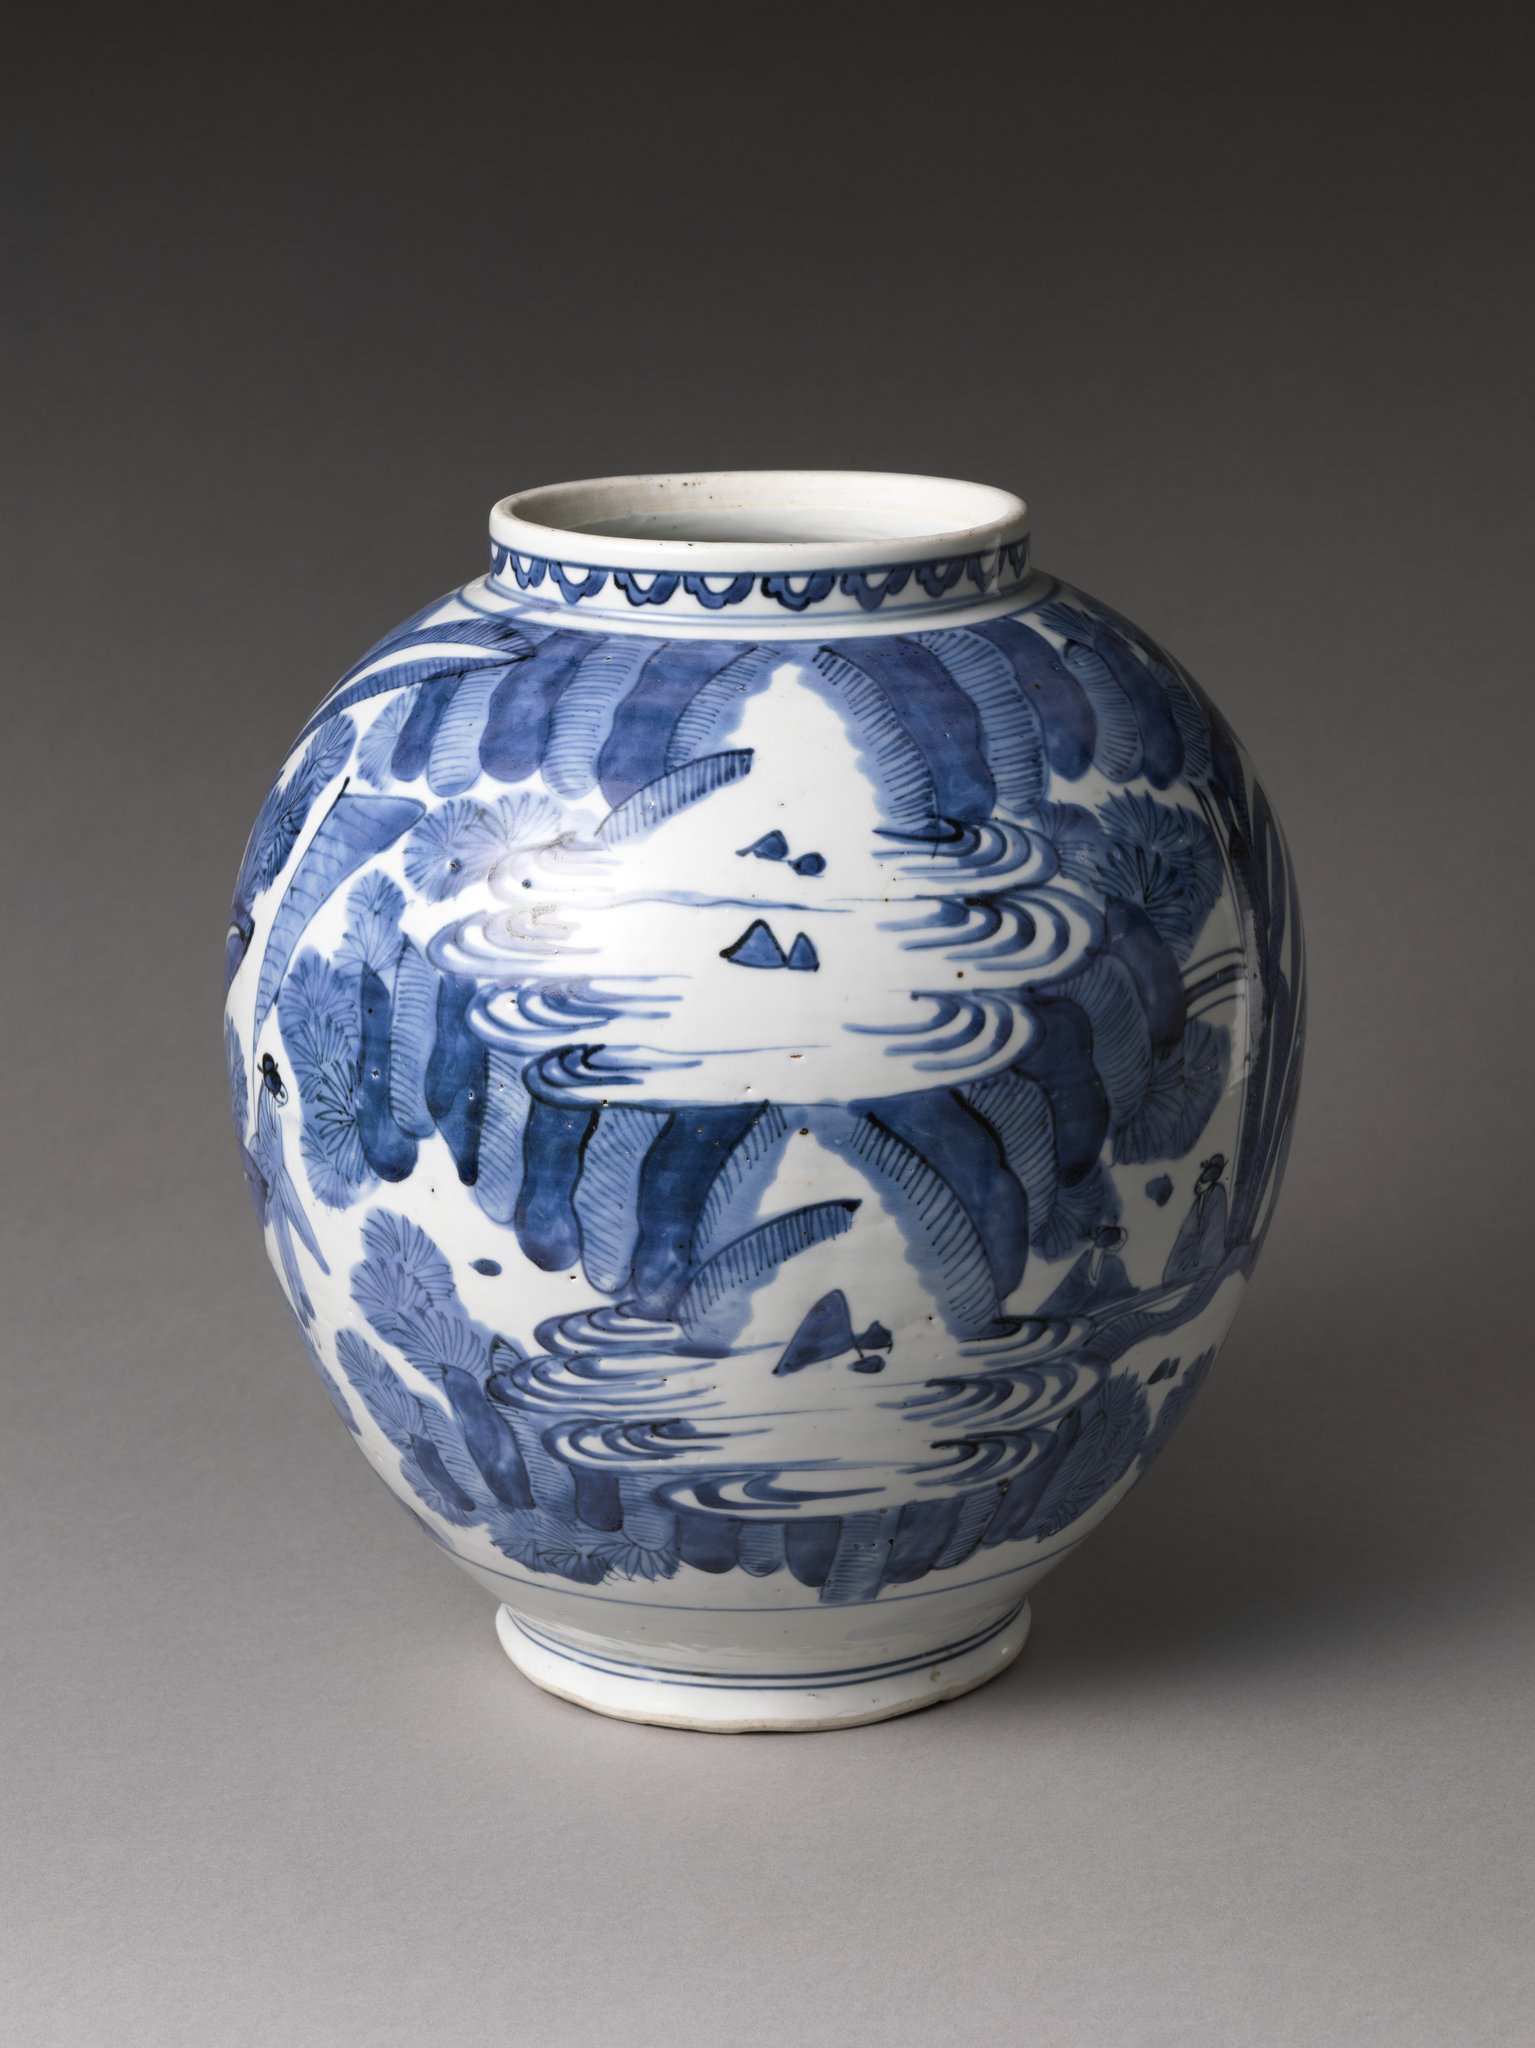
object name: vase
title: Vase with Figures in Landscape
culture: japanese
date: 1660-1680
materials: cobalt, glaze, porcelain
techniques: painting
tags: human figures,landscapes